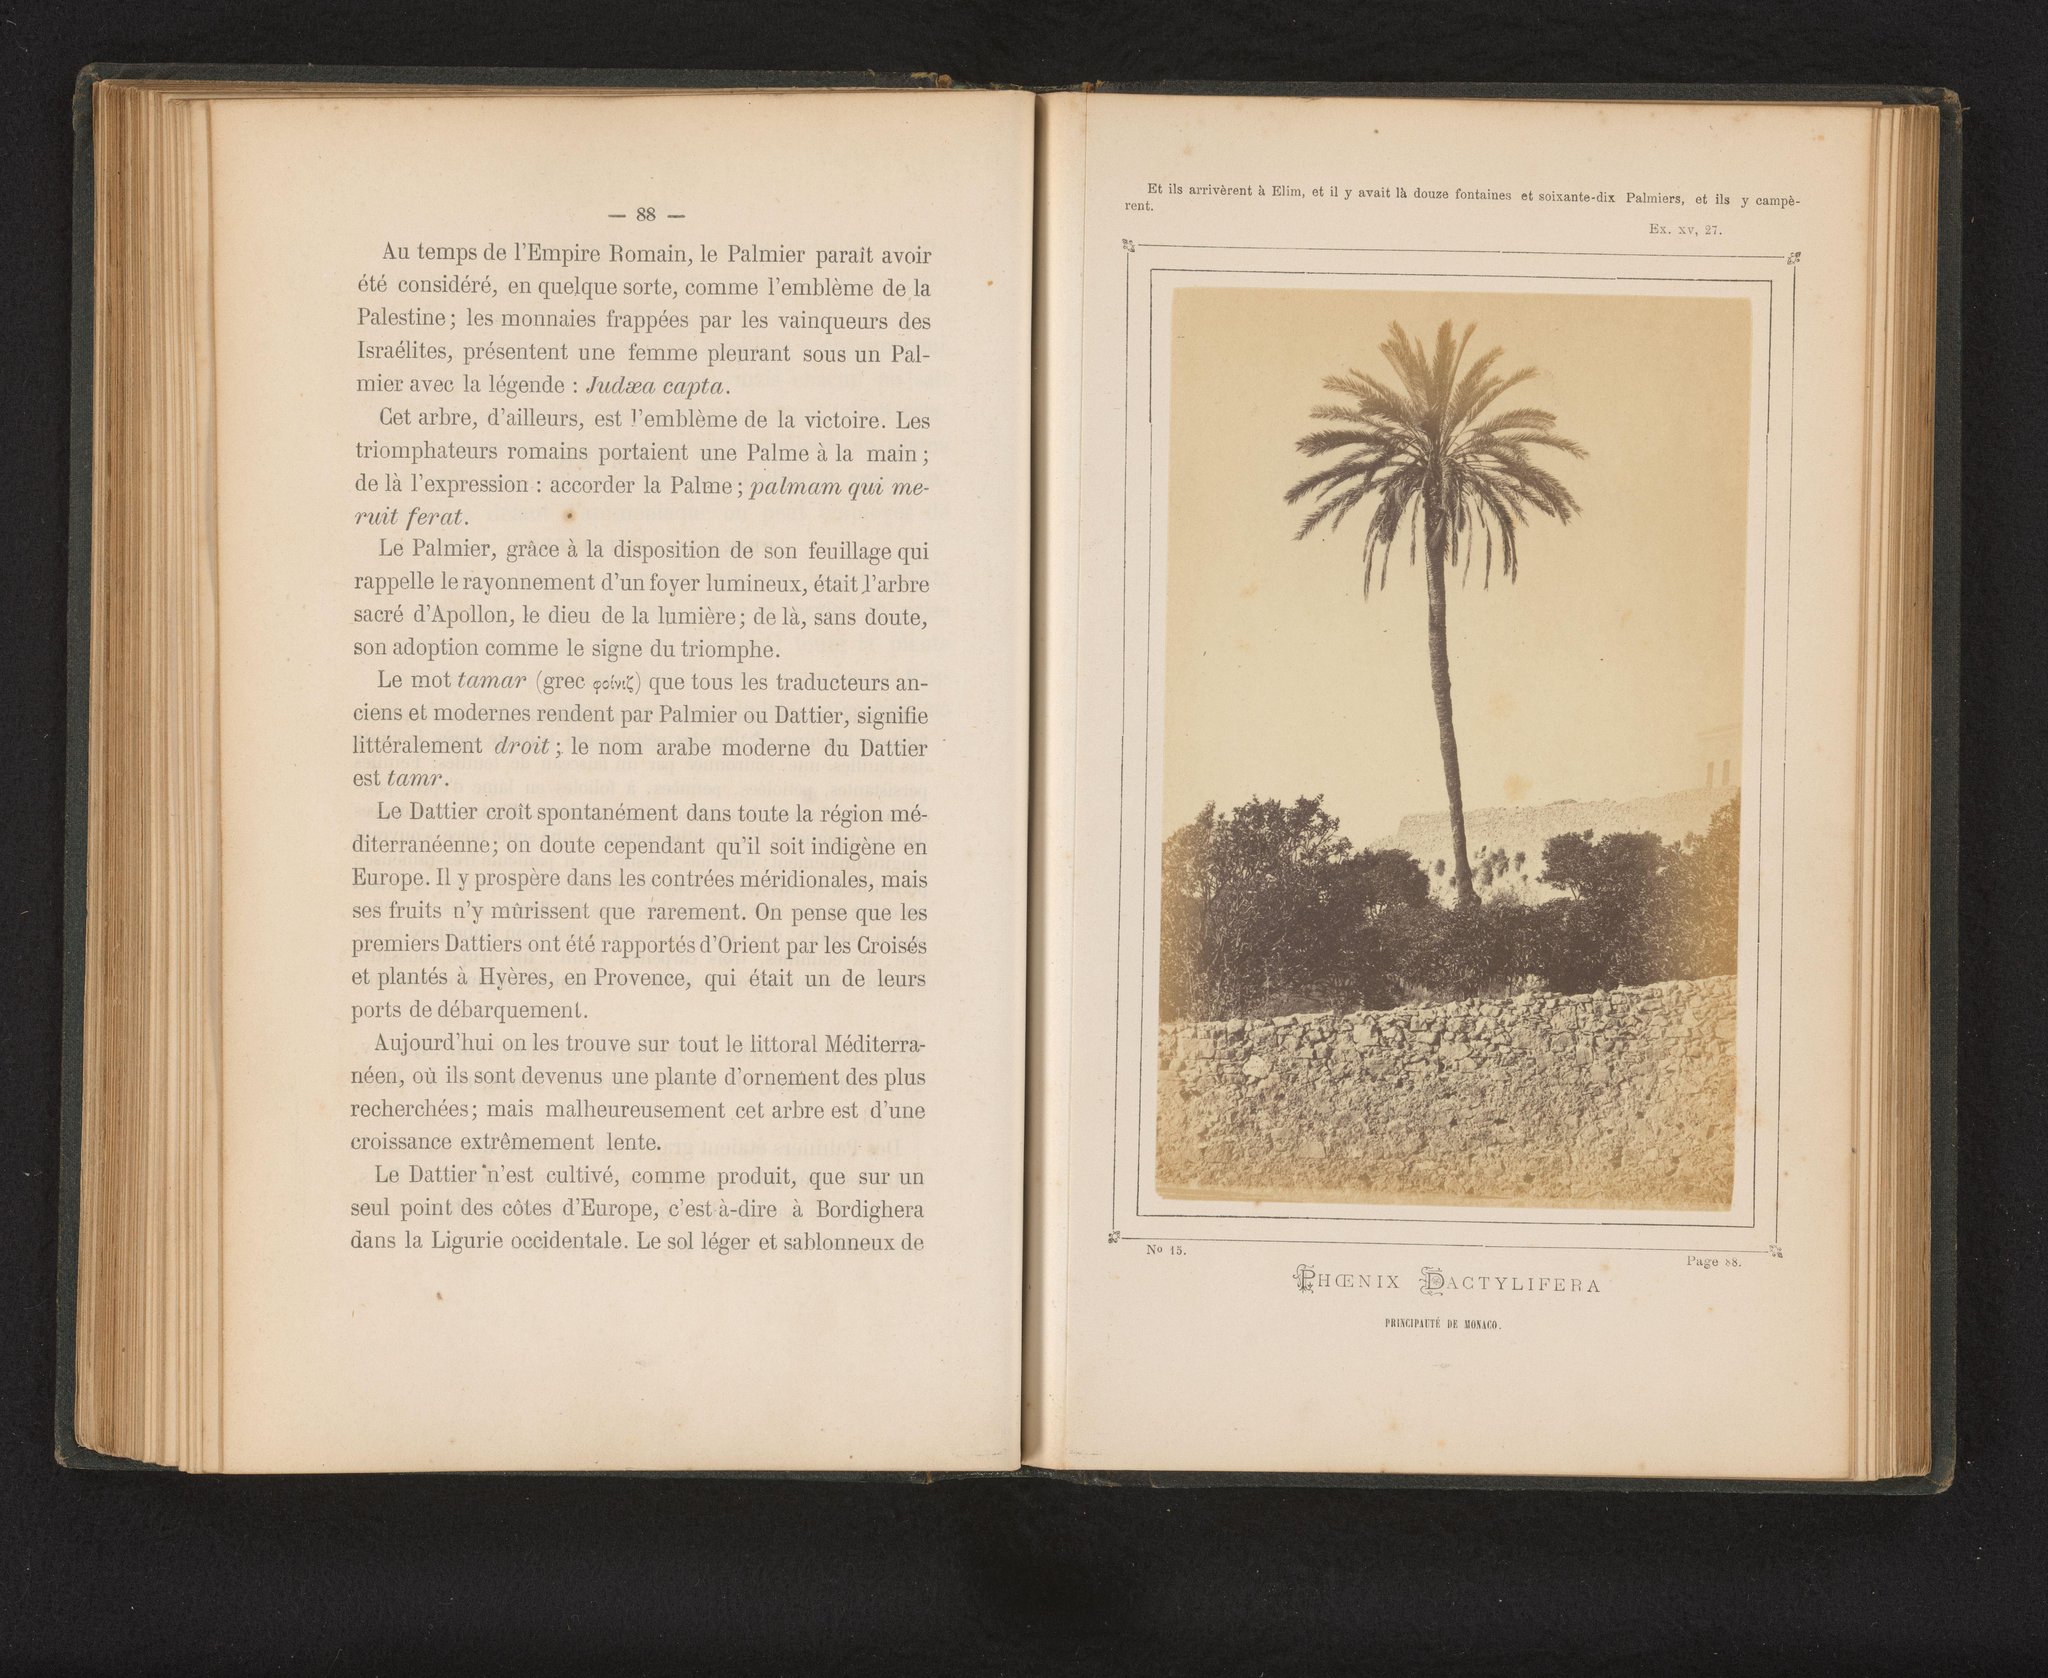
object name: page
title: Phoenix Dactylifera. Principaute de Monaco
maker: jean walburg de bray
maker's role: fotograaf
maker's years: 1839-1901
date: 1866-1871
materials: paper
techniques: albumen print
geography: monaco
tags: trees: date-palm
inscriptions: inscription: ‘Et ils arrivèrent à Elim, et il y a avait là douze fontaines et soixante-dix Palmiers, et ils y campè-/rent./ EX. XV, 27.’, number: ‘No 15.’, inscription: ‘Page 88.’